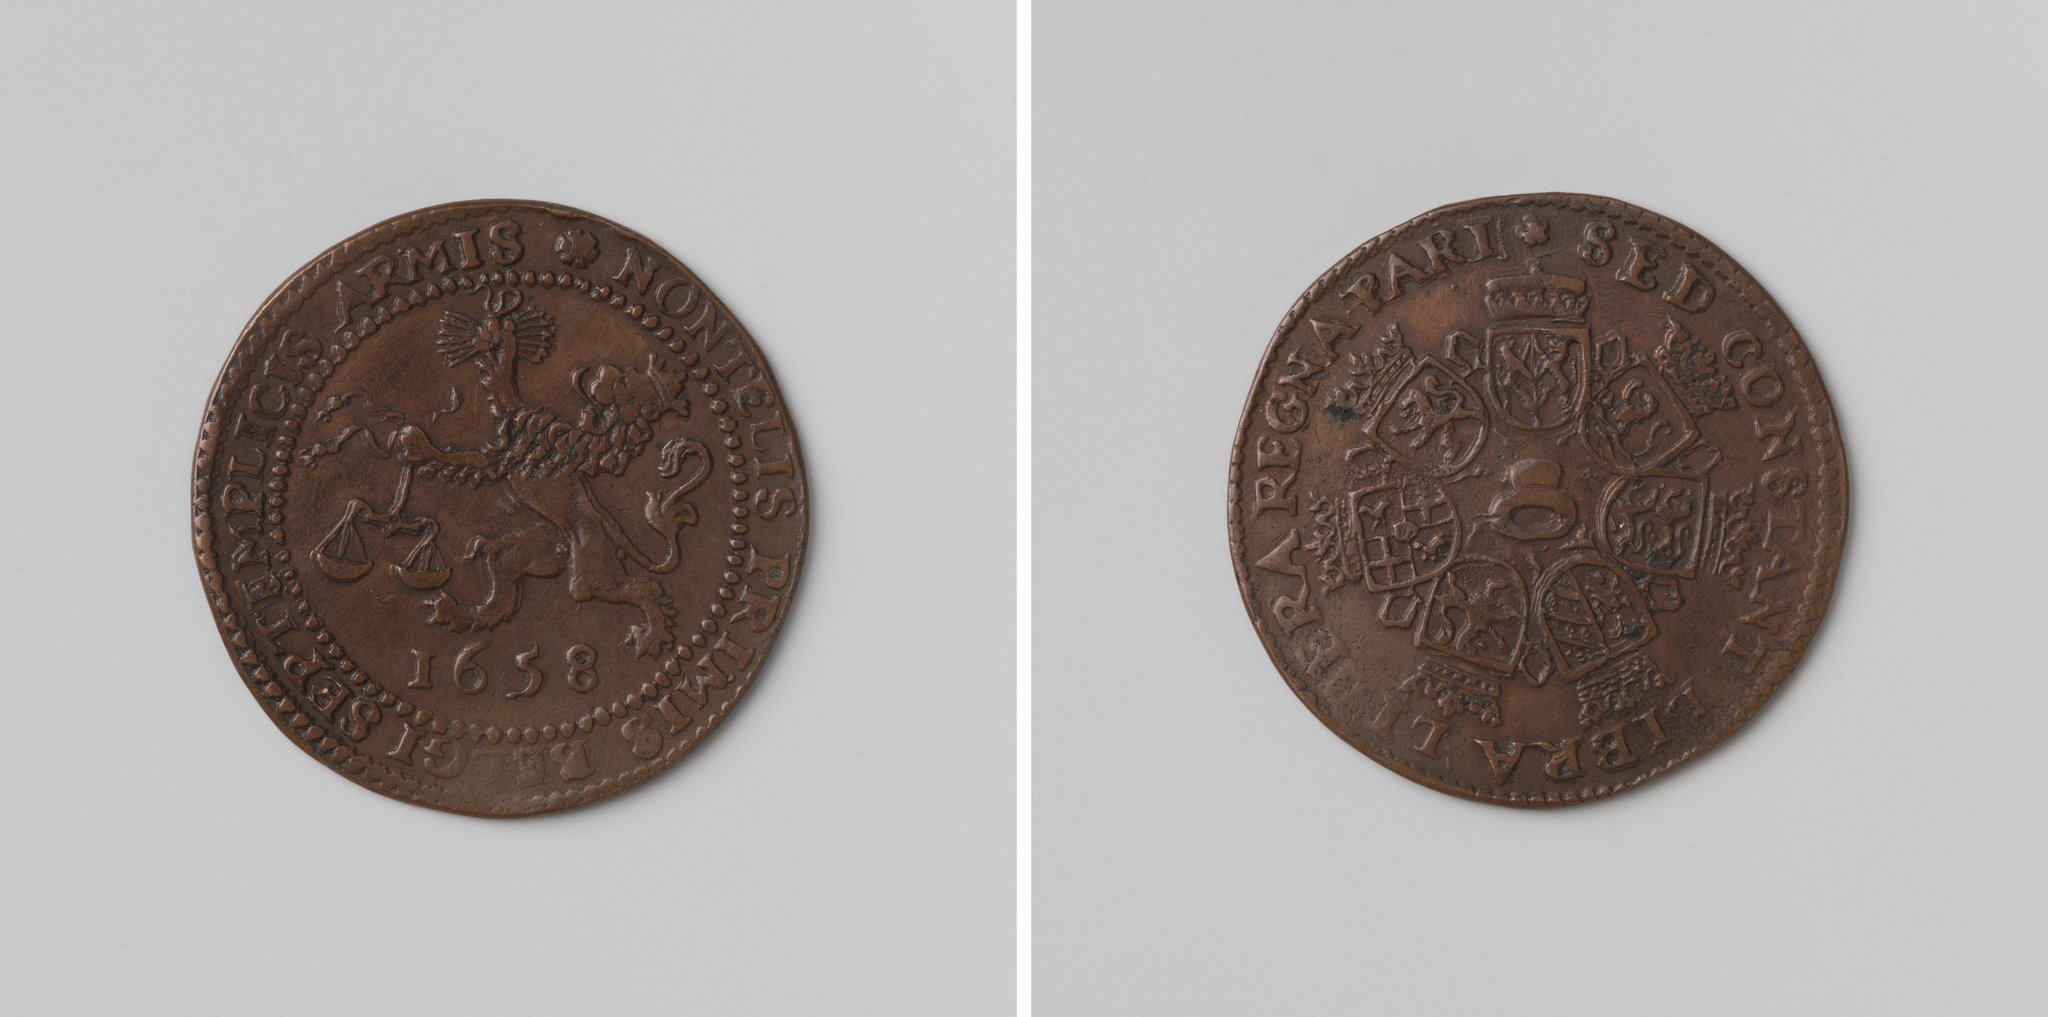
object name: jeton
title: Steun van de Verenigde Nederlanden aan Denemarken in de oorlog met Zweden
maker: Anonymous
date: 1658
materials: copper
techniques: striking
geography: netherlands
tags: faeröer, zweden, noordse oorlogen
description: Koperen penning. Voorzijde: gekroonde leeuw met bundel van zeven pijlen in rechter- en weegschaal in linkerklauw boven jaartal binnen omschrift. Keerzijde: vrijheidshoed, omgeven door rand van zeven met lint samengebonden gekroonde wapenschilden binnen omschrift